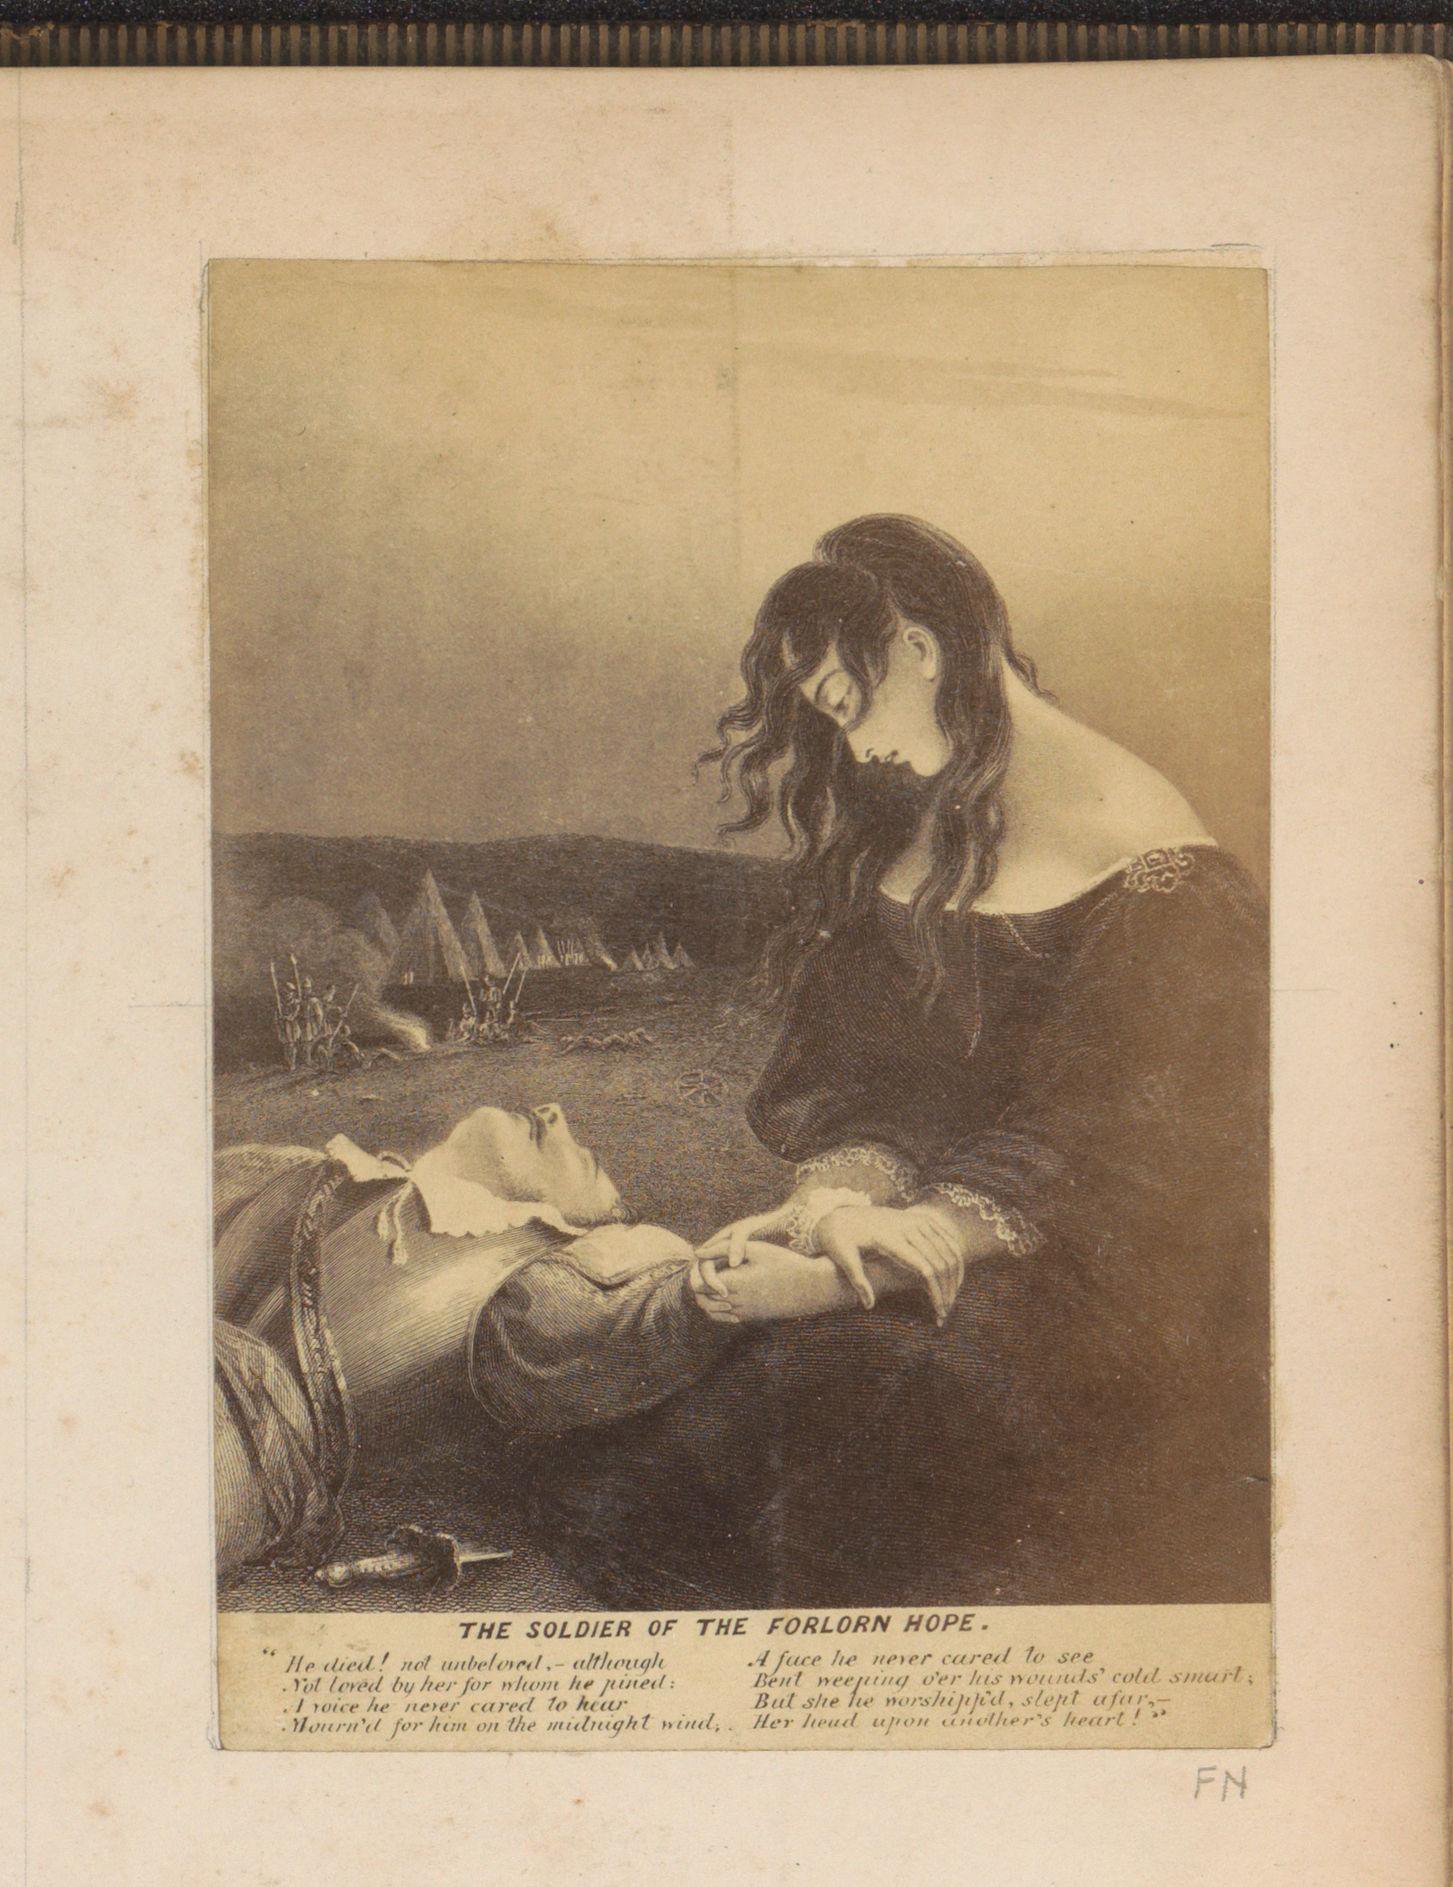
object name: reproduction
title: The soldier of the forlorn hope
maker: Anonymous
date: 1850-1870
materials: paper, photographic support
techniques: albumen print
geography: england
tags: mourning the dead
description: Onderdeel van Album met foto's van bezienswaardigheden en landschappen in Engeland en van kunst.